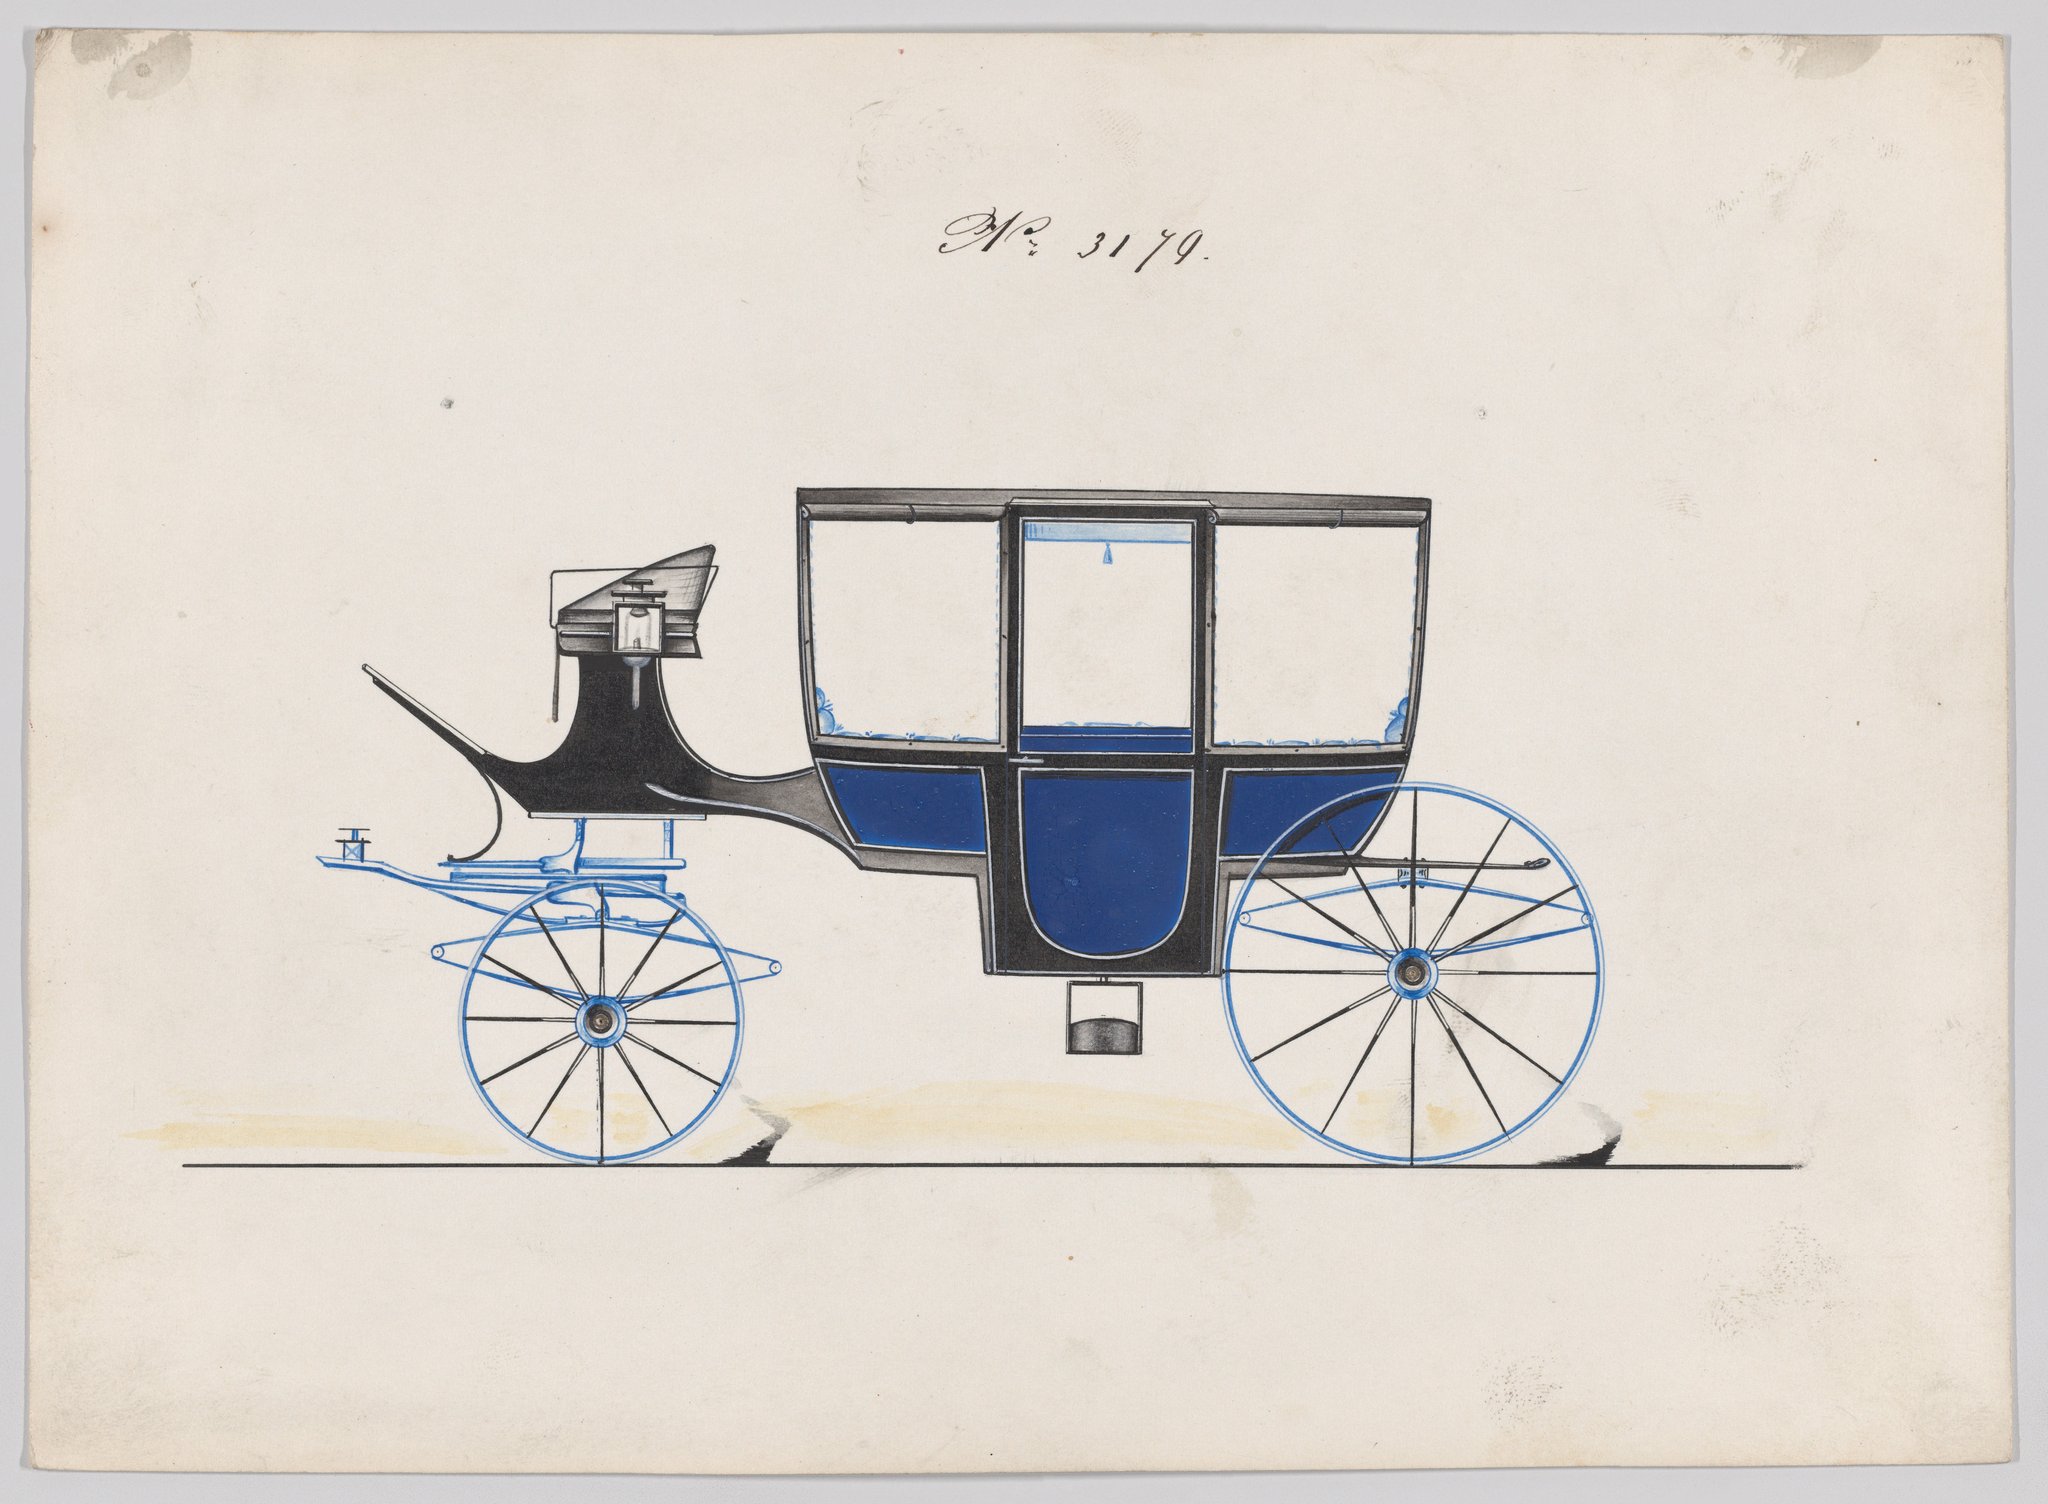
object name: drawing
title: Coach #3179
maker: brewster & co.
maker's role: manufacturer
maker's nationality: american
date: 1875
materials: gouache, ink, watercolor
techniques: pen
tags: carriages